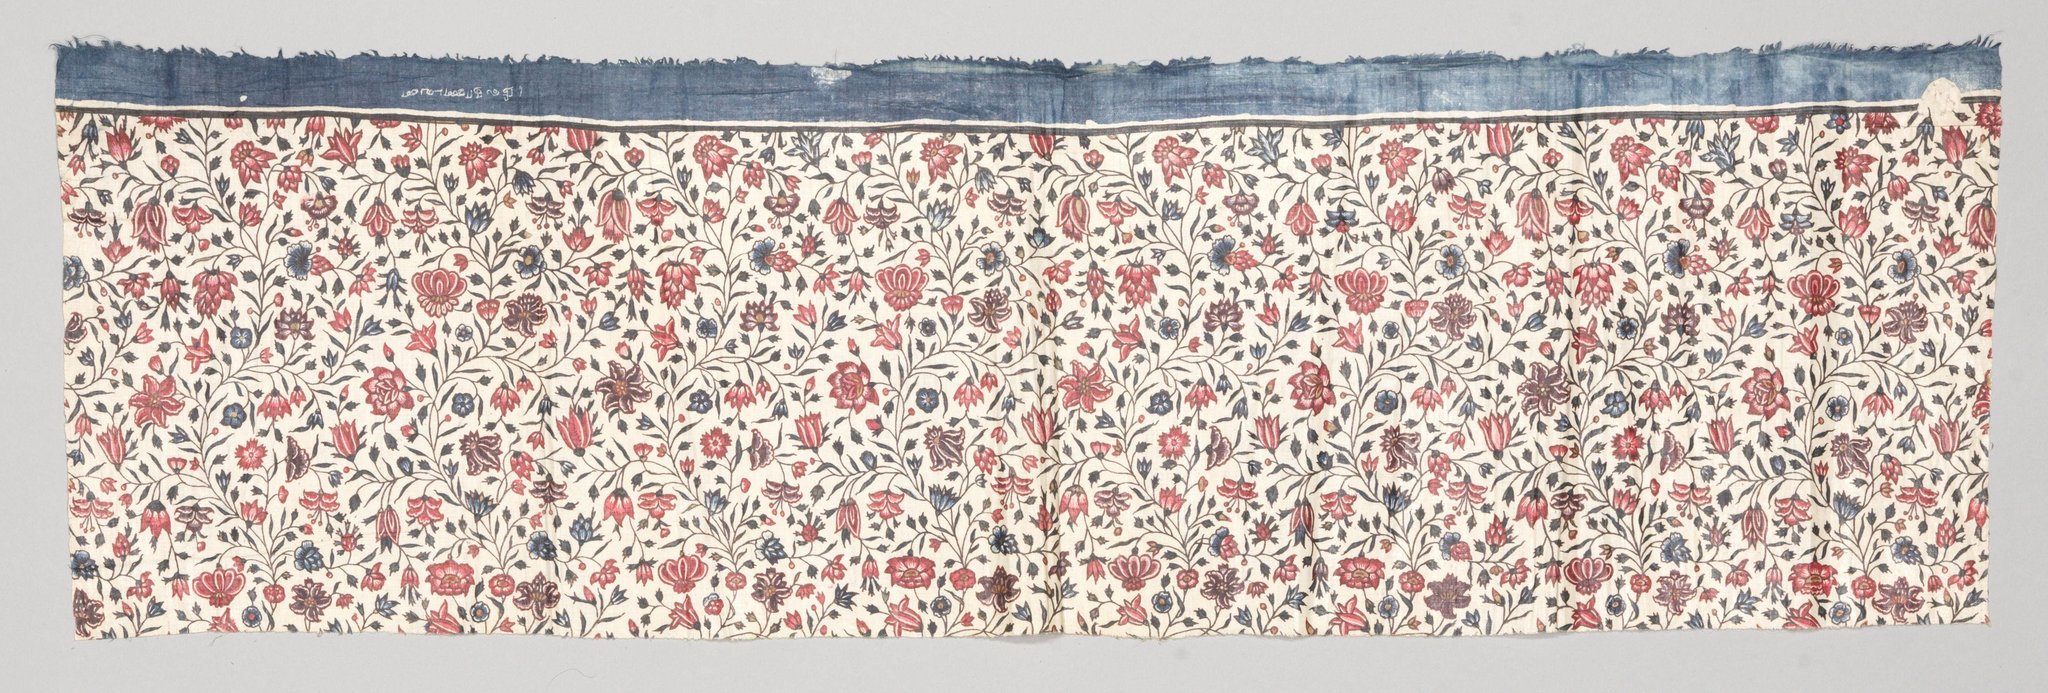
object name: fragment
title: Fragment sits met een patroon van twijgen met kleine bloemen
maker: Anonymous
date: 1750-1775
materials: cotton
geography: paliacatta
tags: verenigde oostindische compagnie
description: Fragment sits met een doorlopend patroon van bloemtakken in verschillende tinten rood, aubergine, blauw en groen met omtrekken in zwart en rood. Aan de onderzijde een blauwe rand met links witte ronde uitsparing in het blauw met resten van VOC(?) of EIC(?) merk en links in dito inscriptie in Tamil (I. Niladantavan); rechts (volgens opgave in jaarmap aan achterzijde in hoek 'VOC'merk) opgespeld papiertje met in 18de eeuws schrift: 'Deze lap uyt het boelgoed/van Abr: Ruuds kost 34 st/ 1783' en 'Van Wijtze de Vries/ 11/16 E1 Zits a 6 GL f 4 - 2 - 11/1775 Augs: 1' en 'W 38/ 34 st'. Oosters textiel.